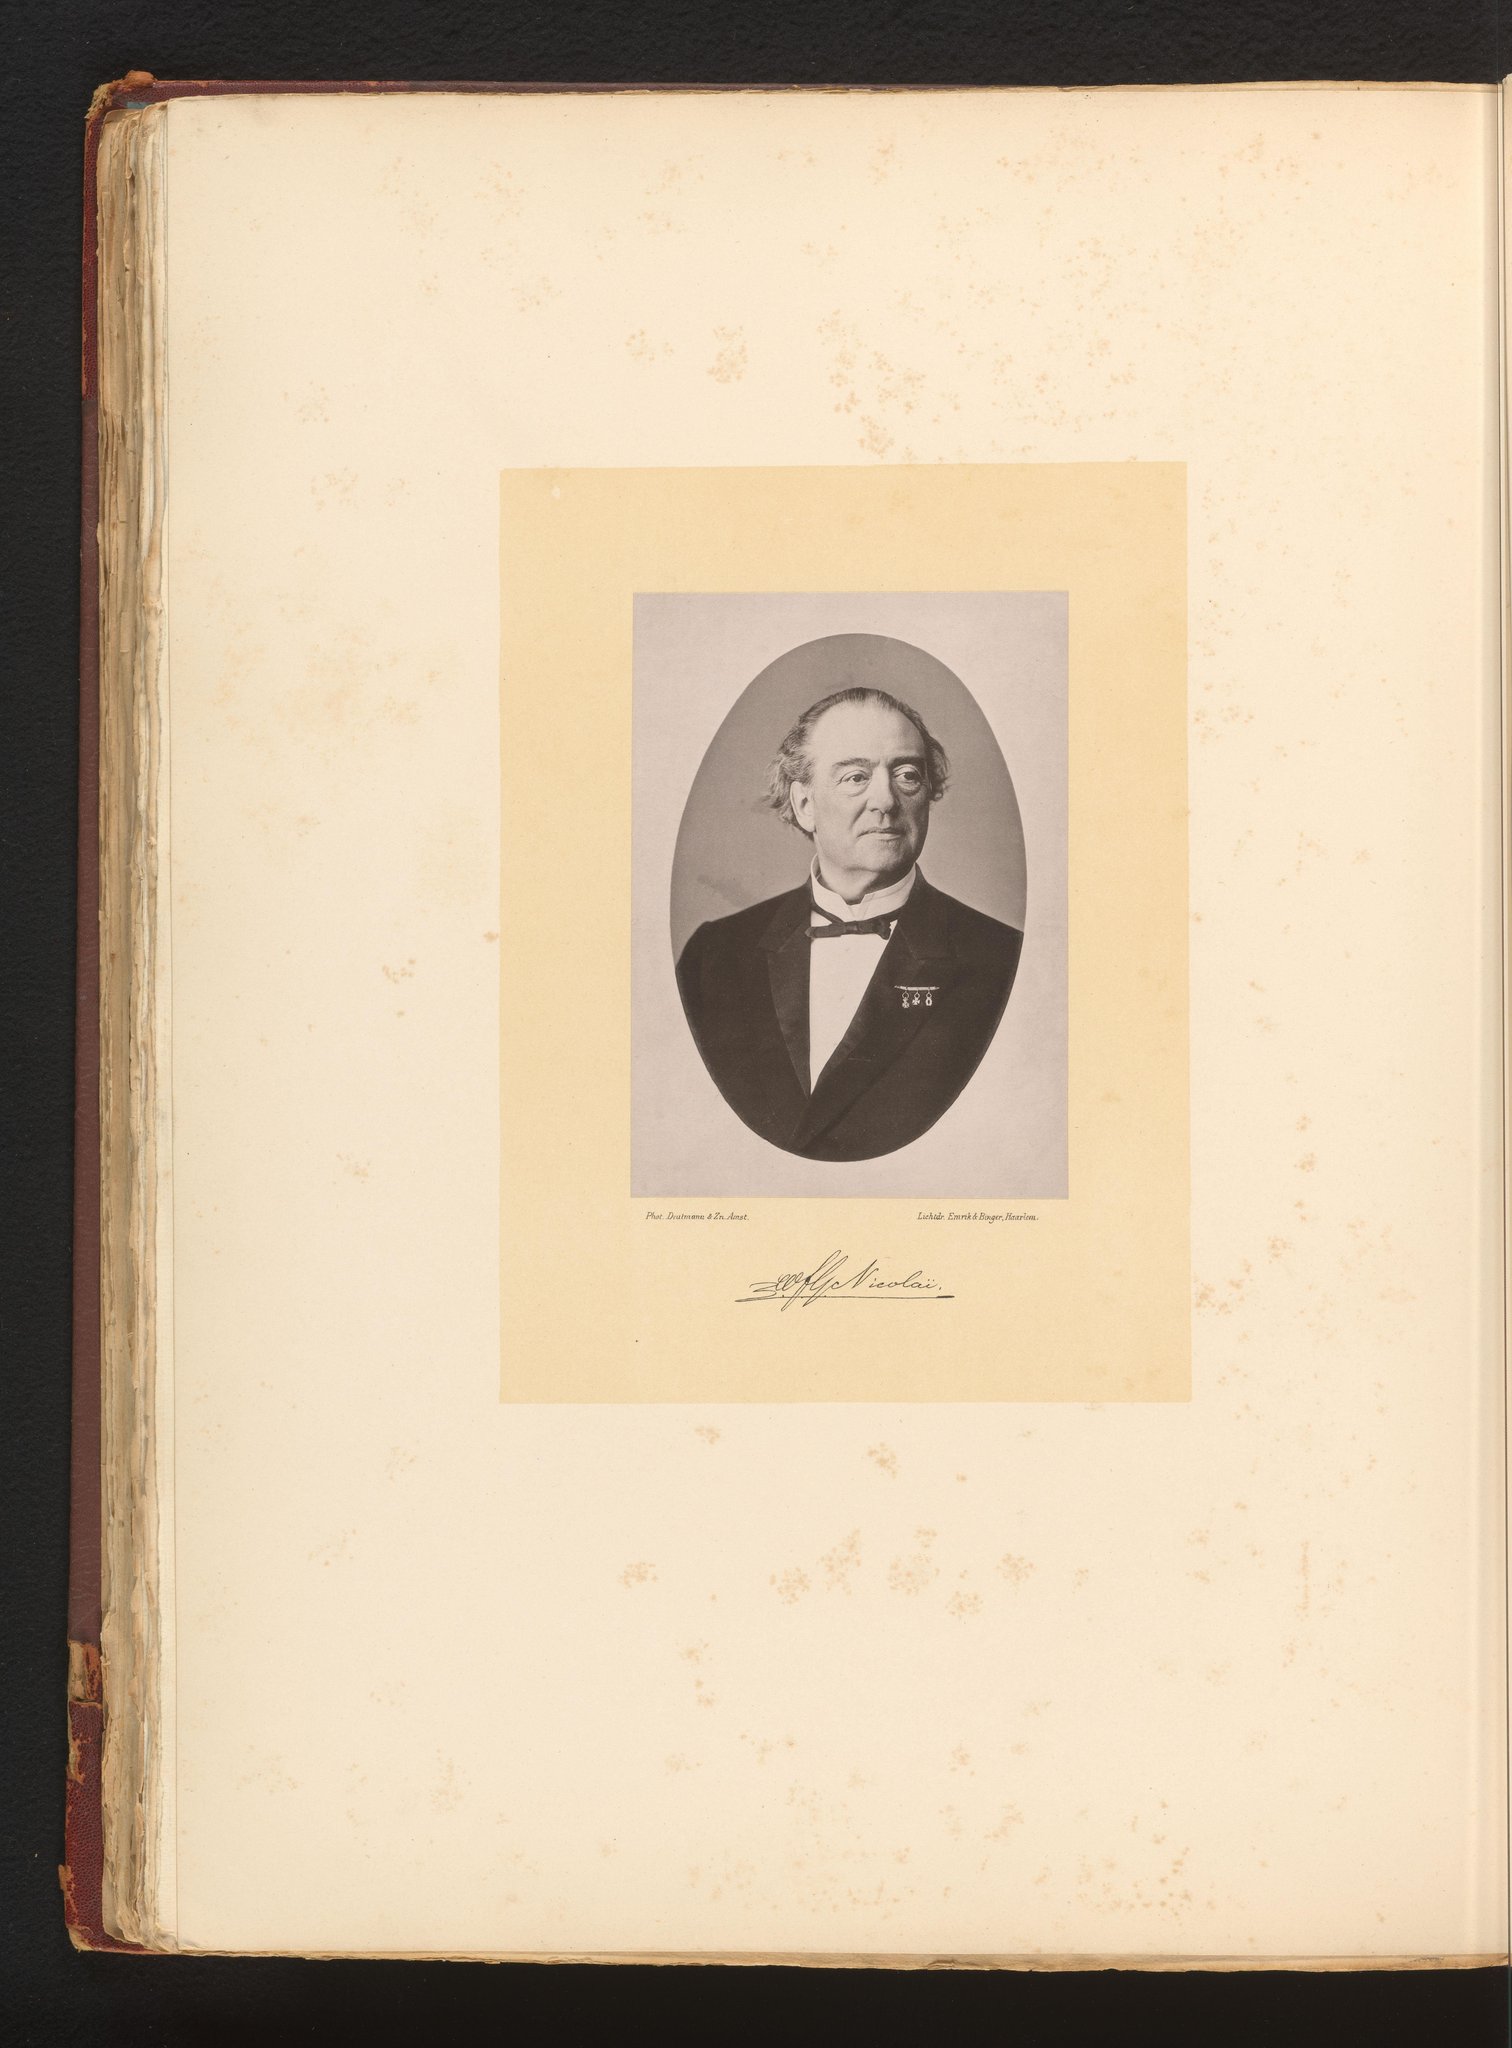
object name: page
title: Portret van Willem Nicolaï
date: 1888-1896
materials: paper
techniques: photograph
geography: haarlem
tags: leiden, the hague, historical persons, portrait of a musician